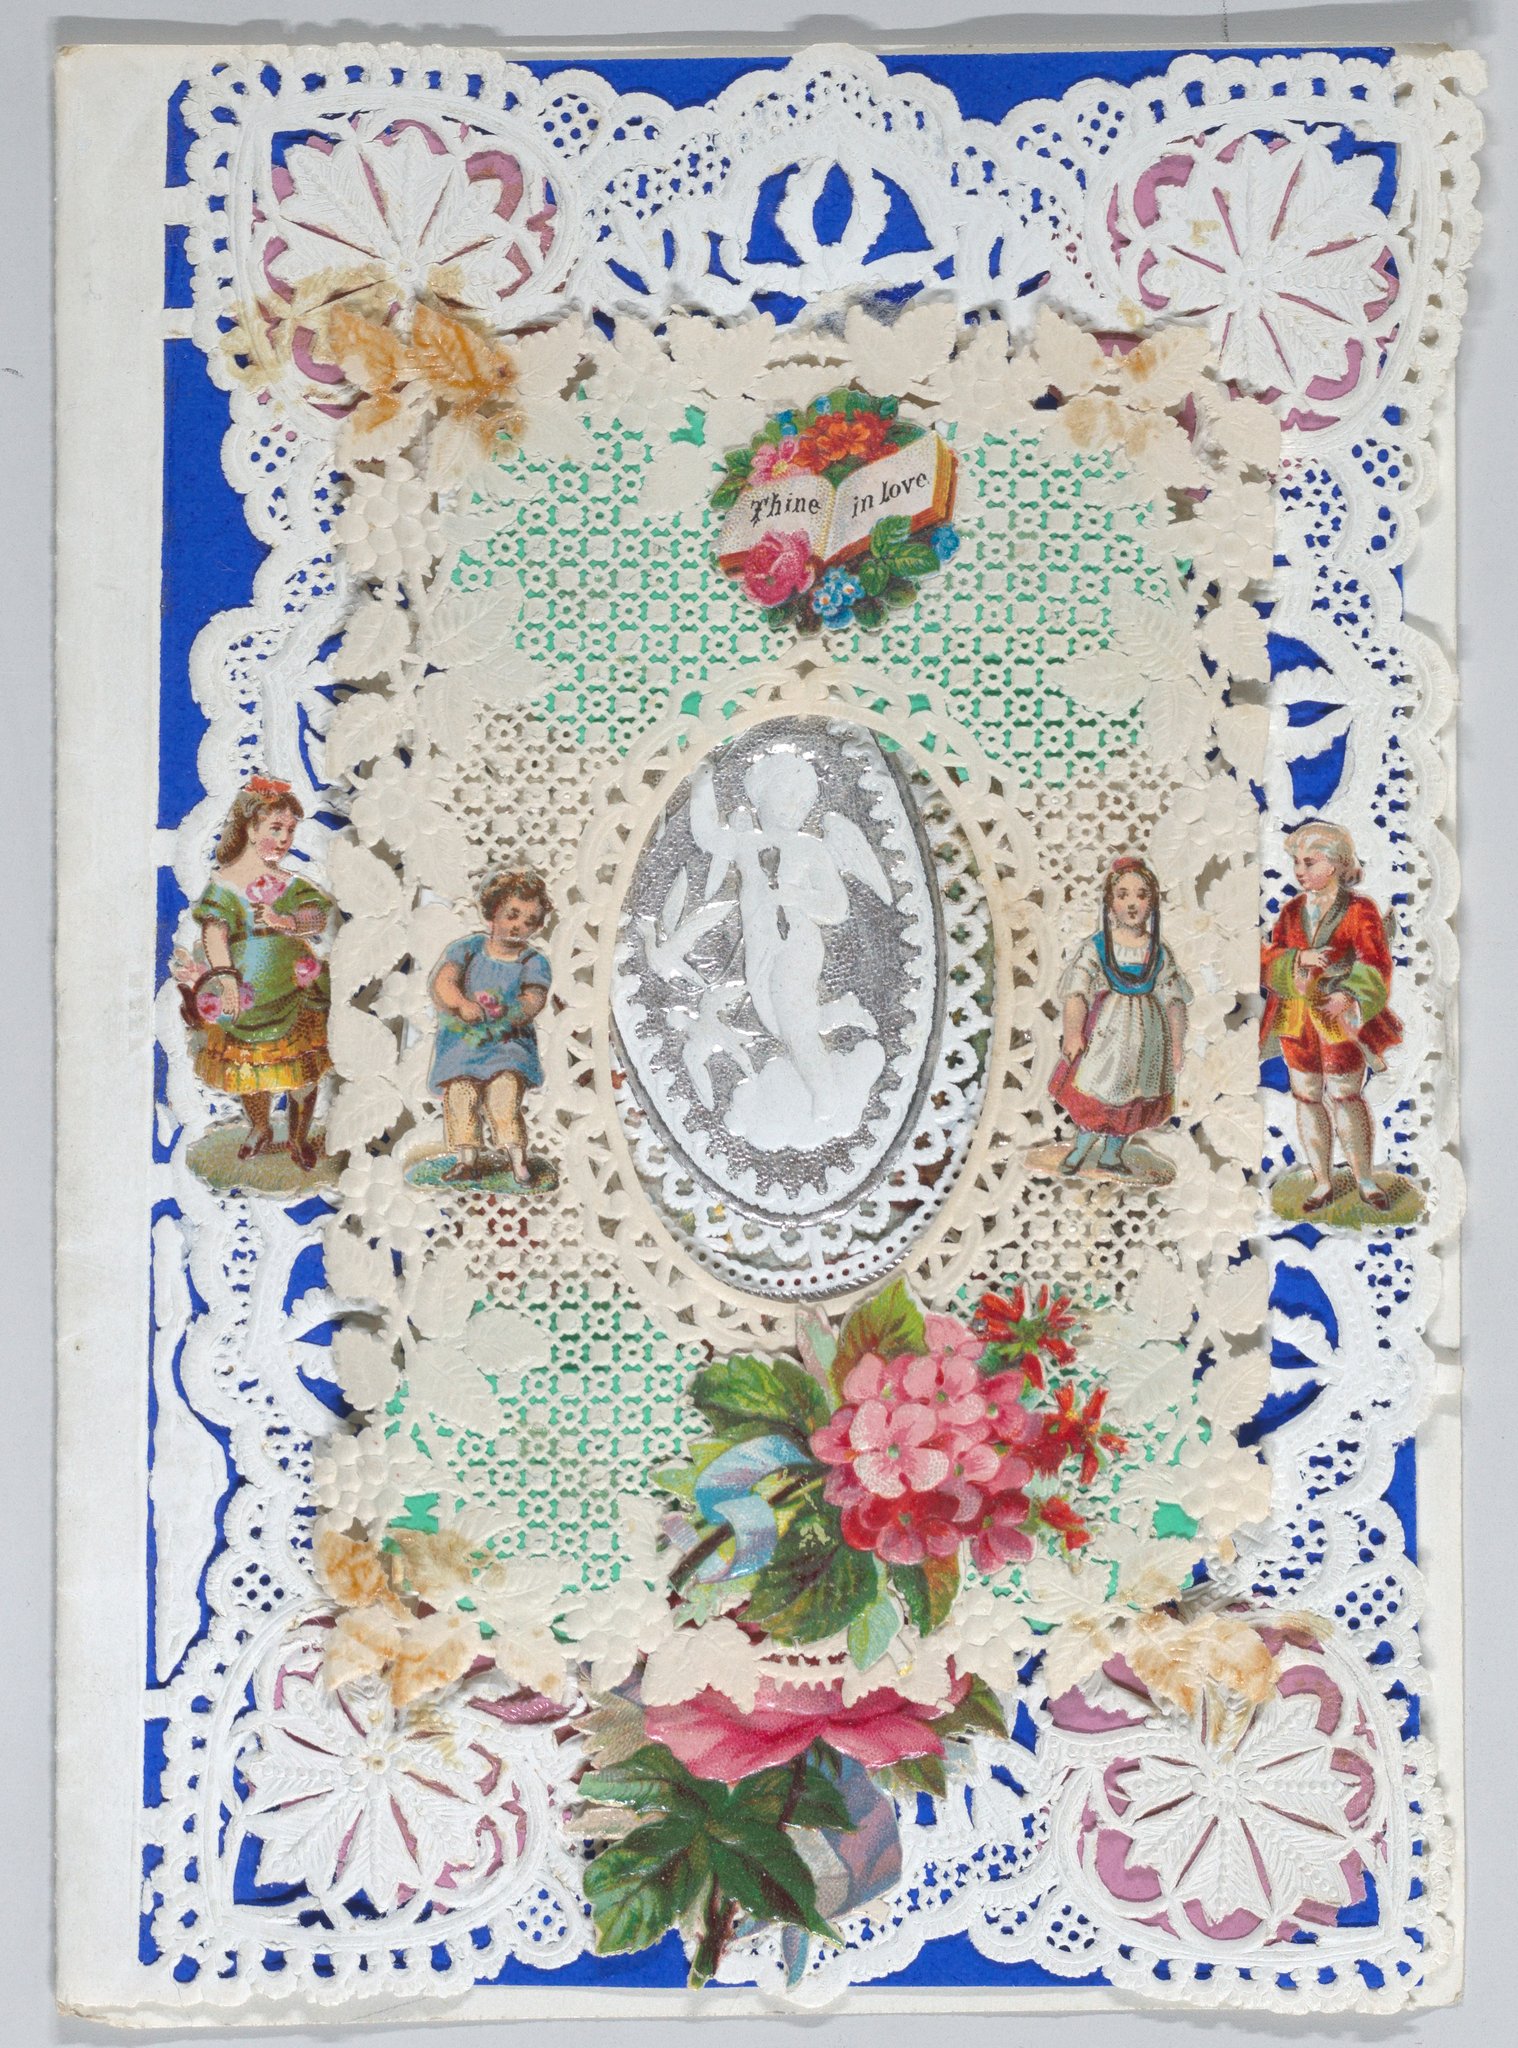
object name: valentine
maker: esther howland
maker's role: artist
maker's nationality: american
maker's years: 1828-1904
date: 1850-1860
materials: graphite, paper, silver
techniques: cutting, embossing, open work